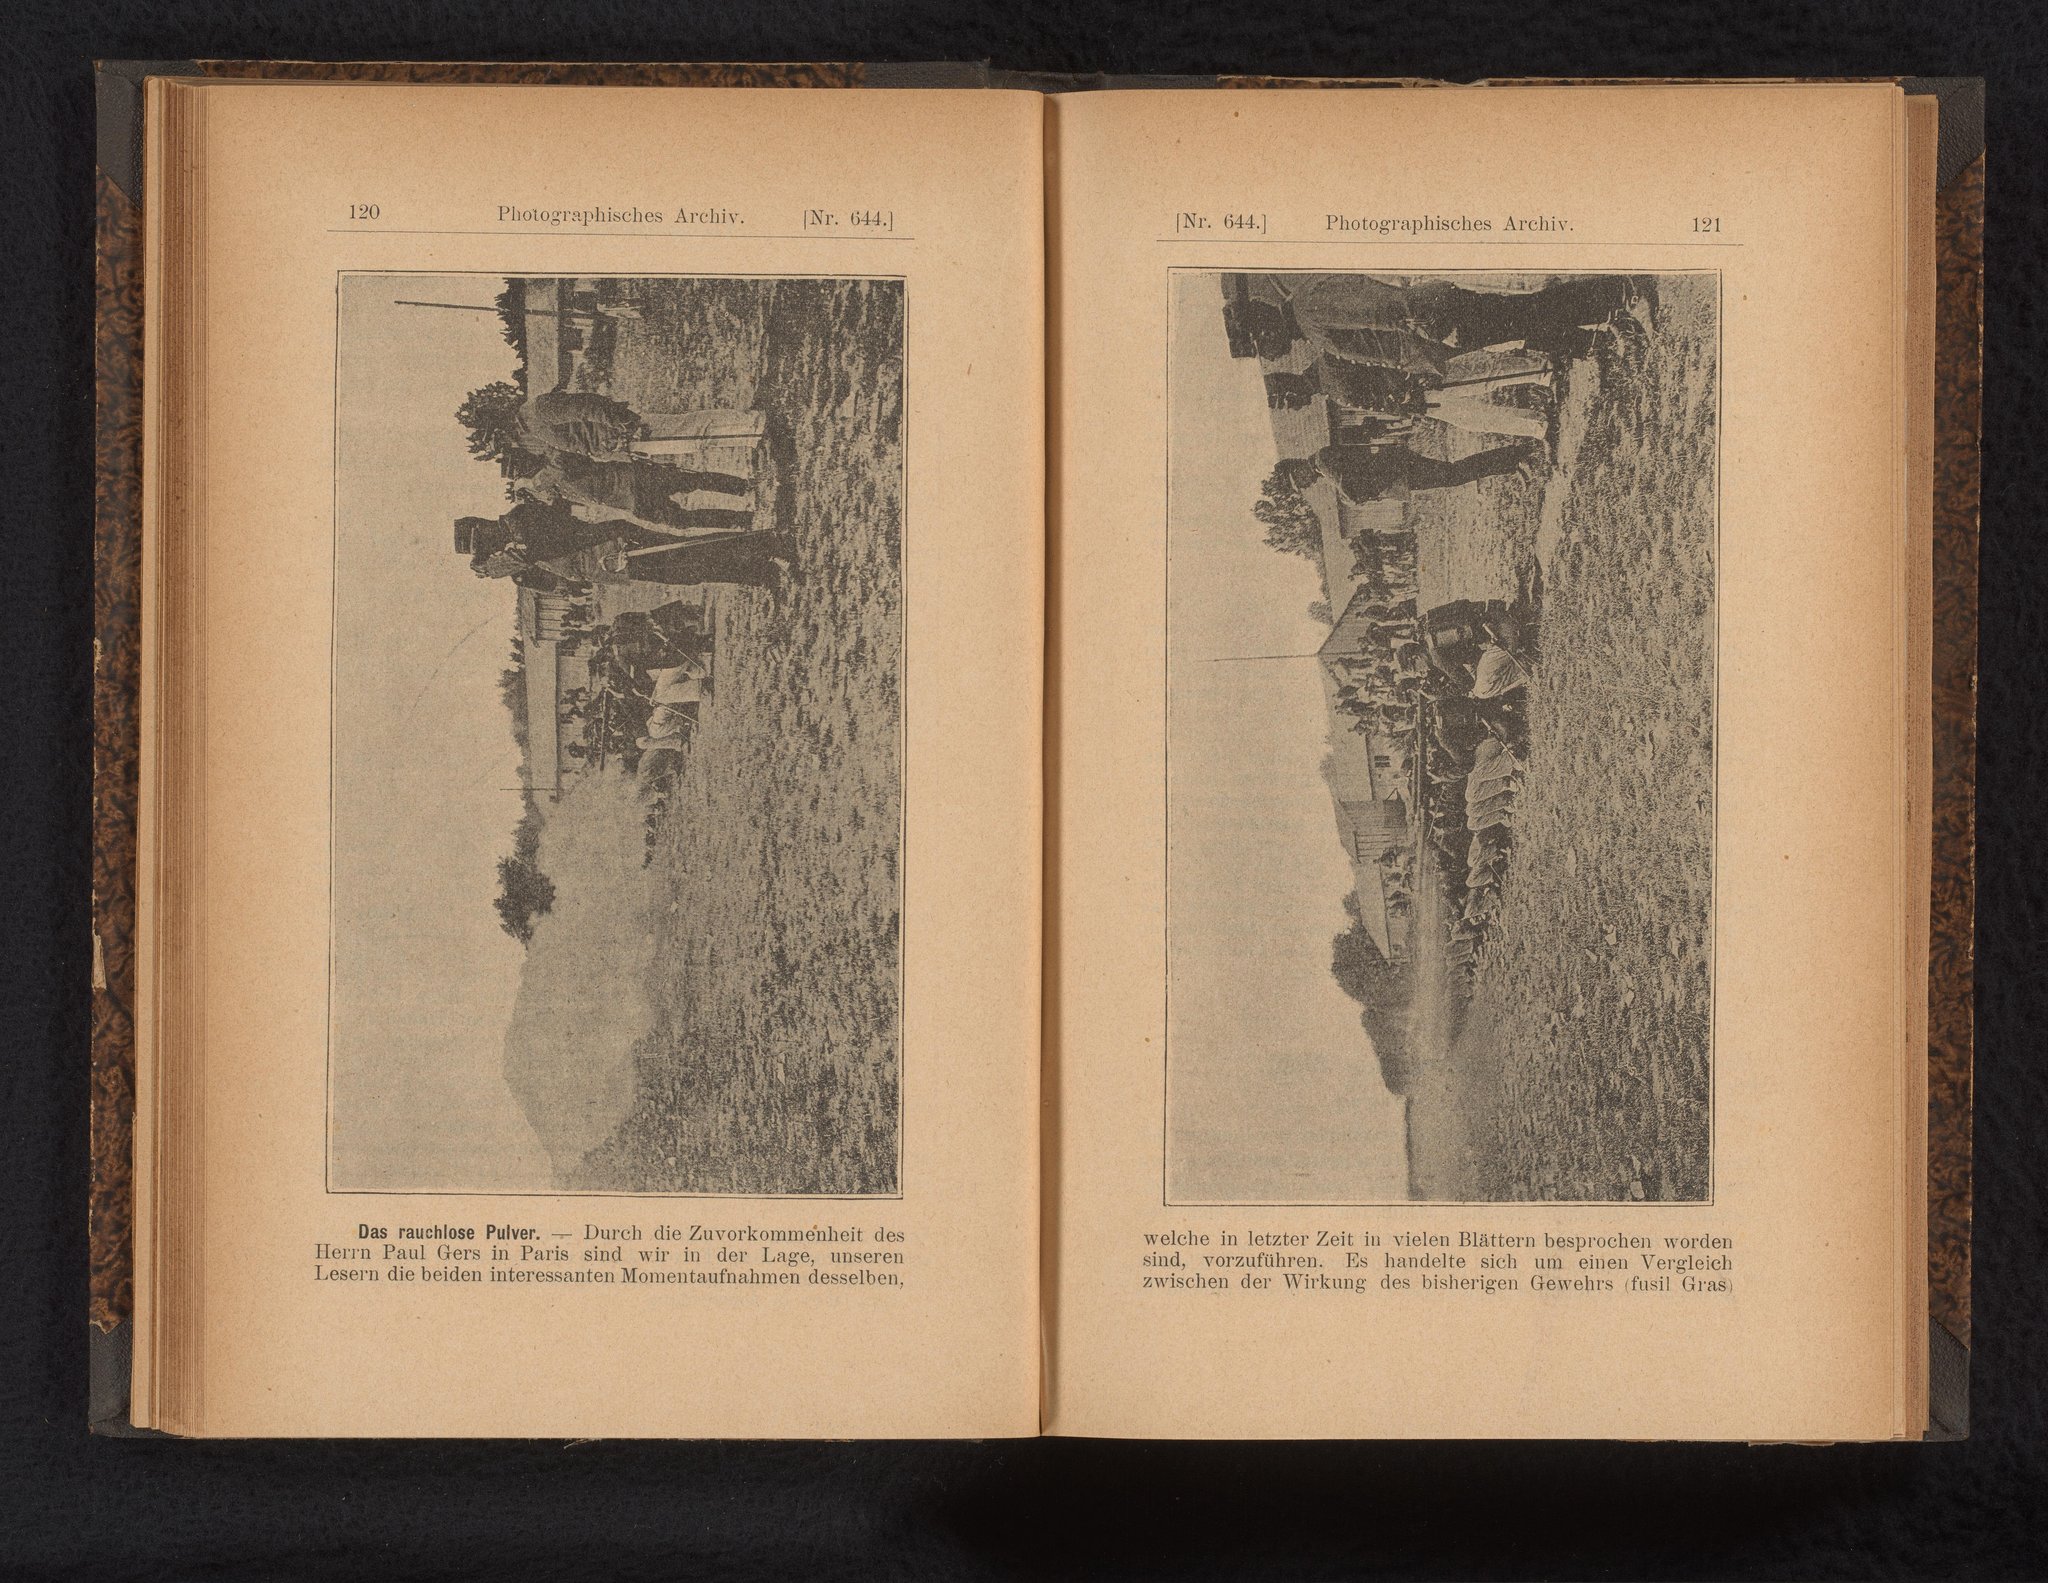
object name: photomechanical print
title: Das rauchlose Pulver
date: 1805-1889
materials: paper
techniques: autotype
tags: artillery range, firing range, shooting range ~ military training, firearms: rifle